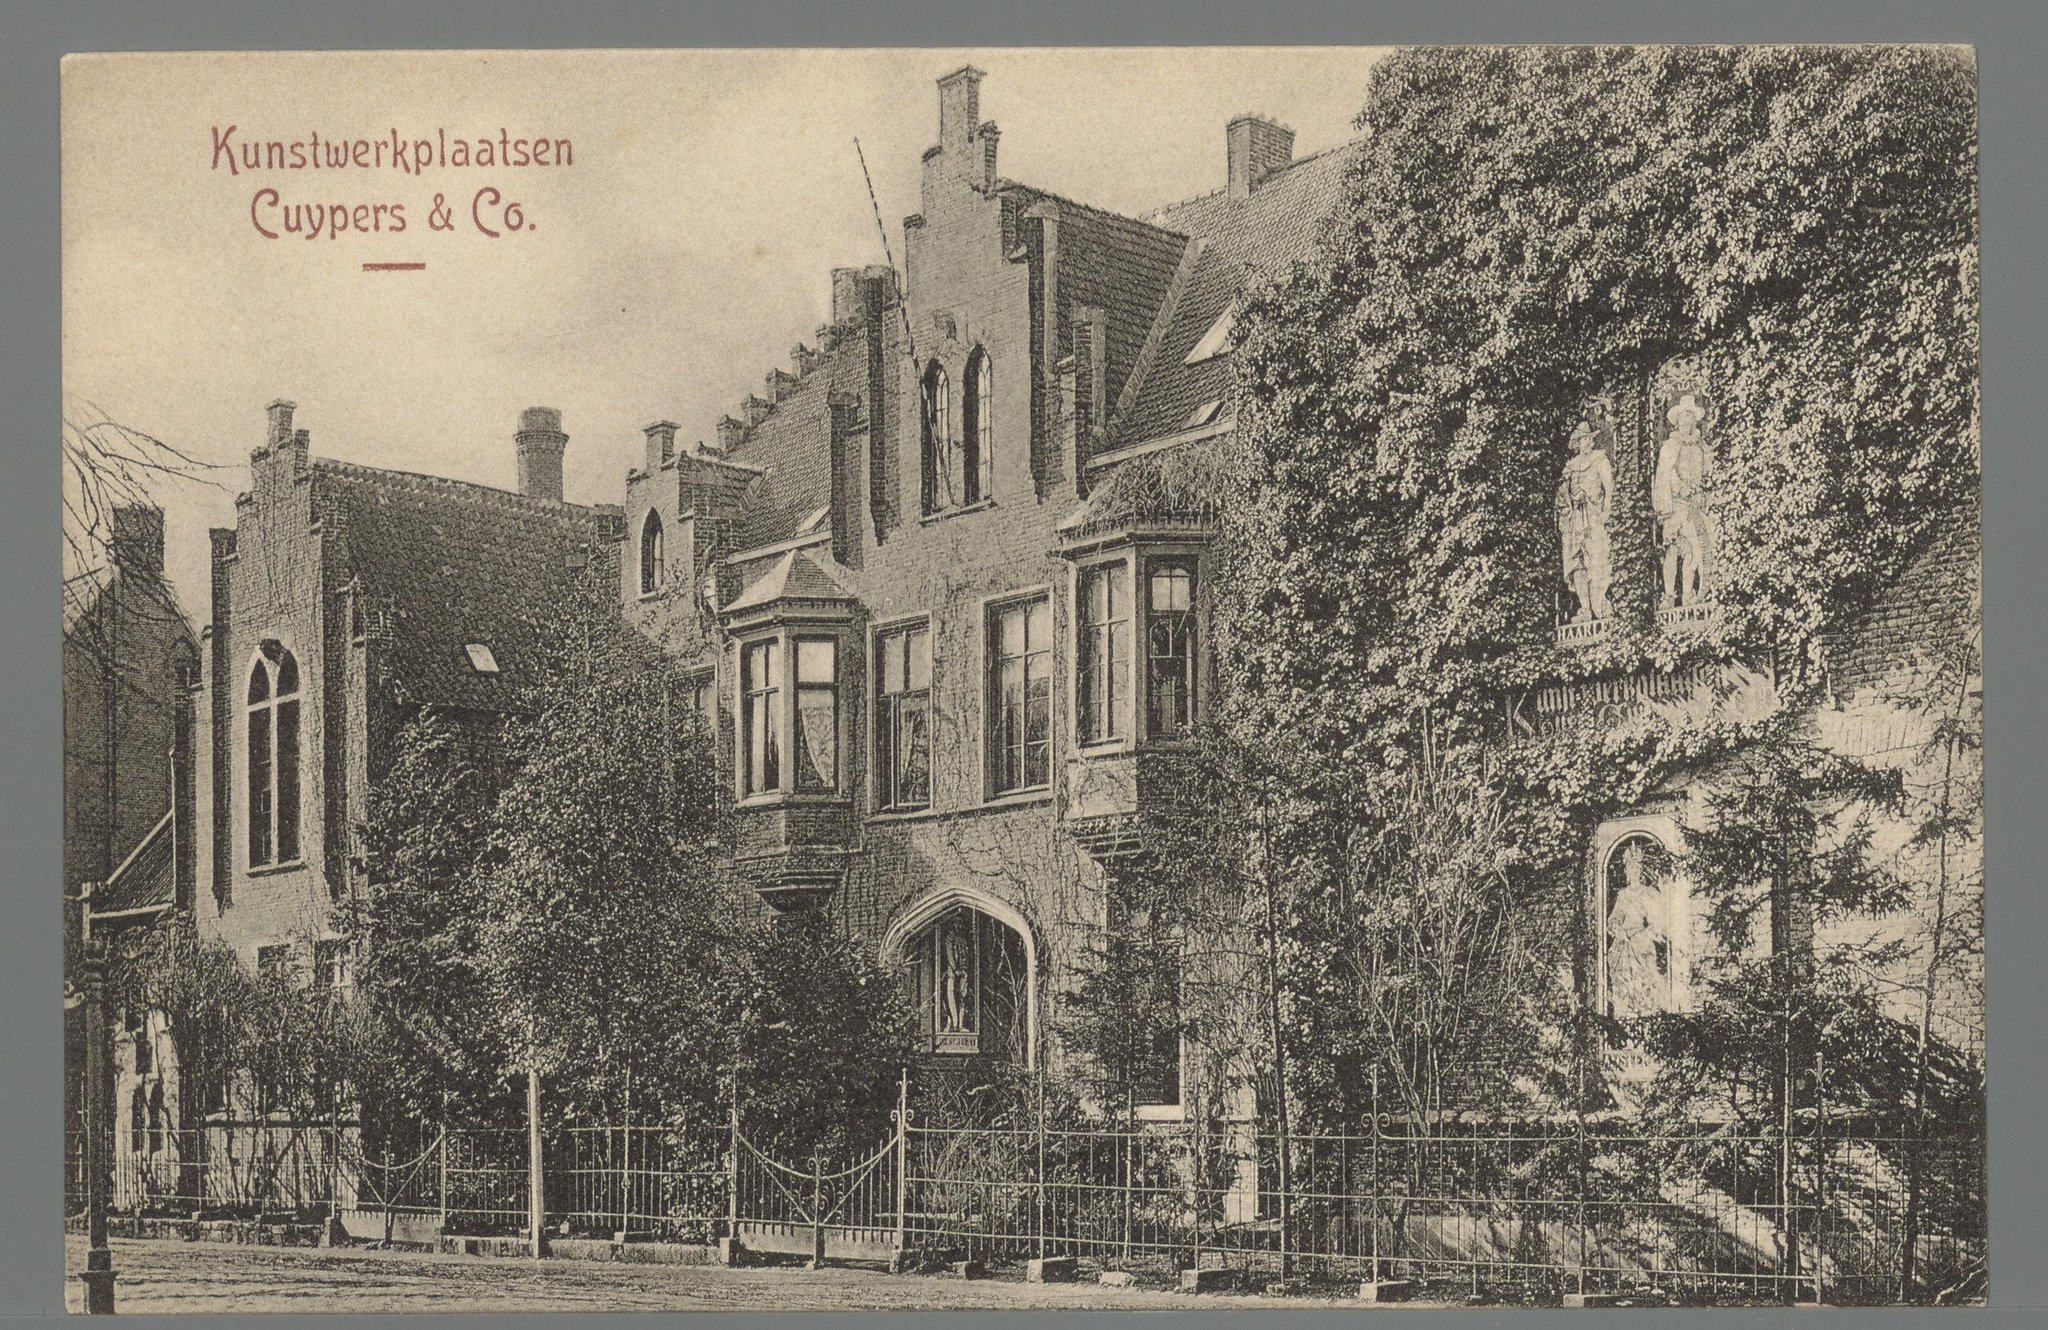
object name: ansichtkaart, prentbriefkaart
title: Kunstwerkplaatsen. Cuypers & Co.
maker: Anonymous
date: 1905-1930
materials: cardboard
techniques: photograph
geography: roermond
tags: workshop